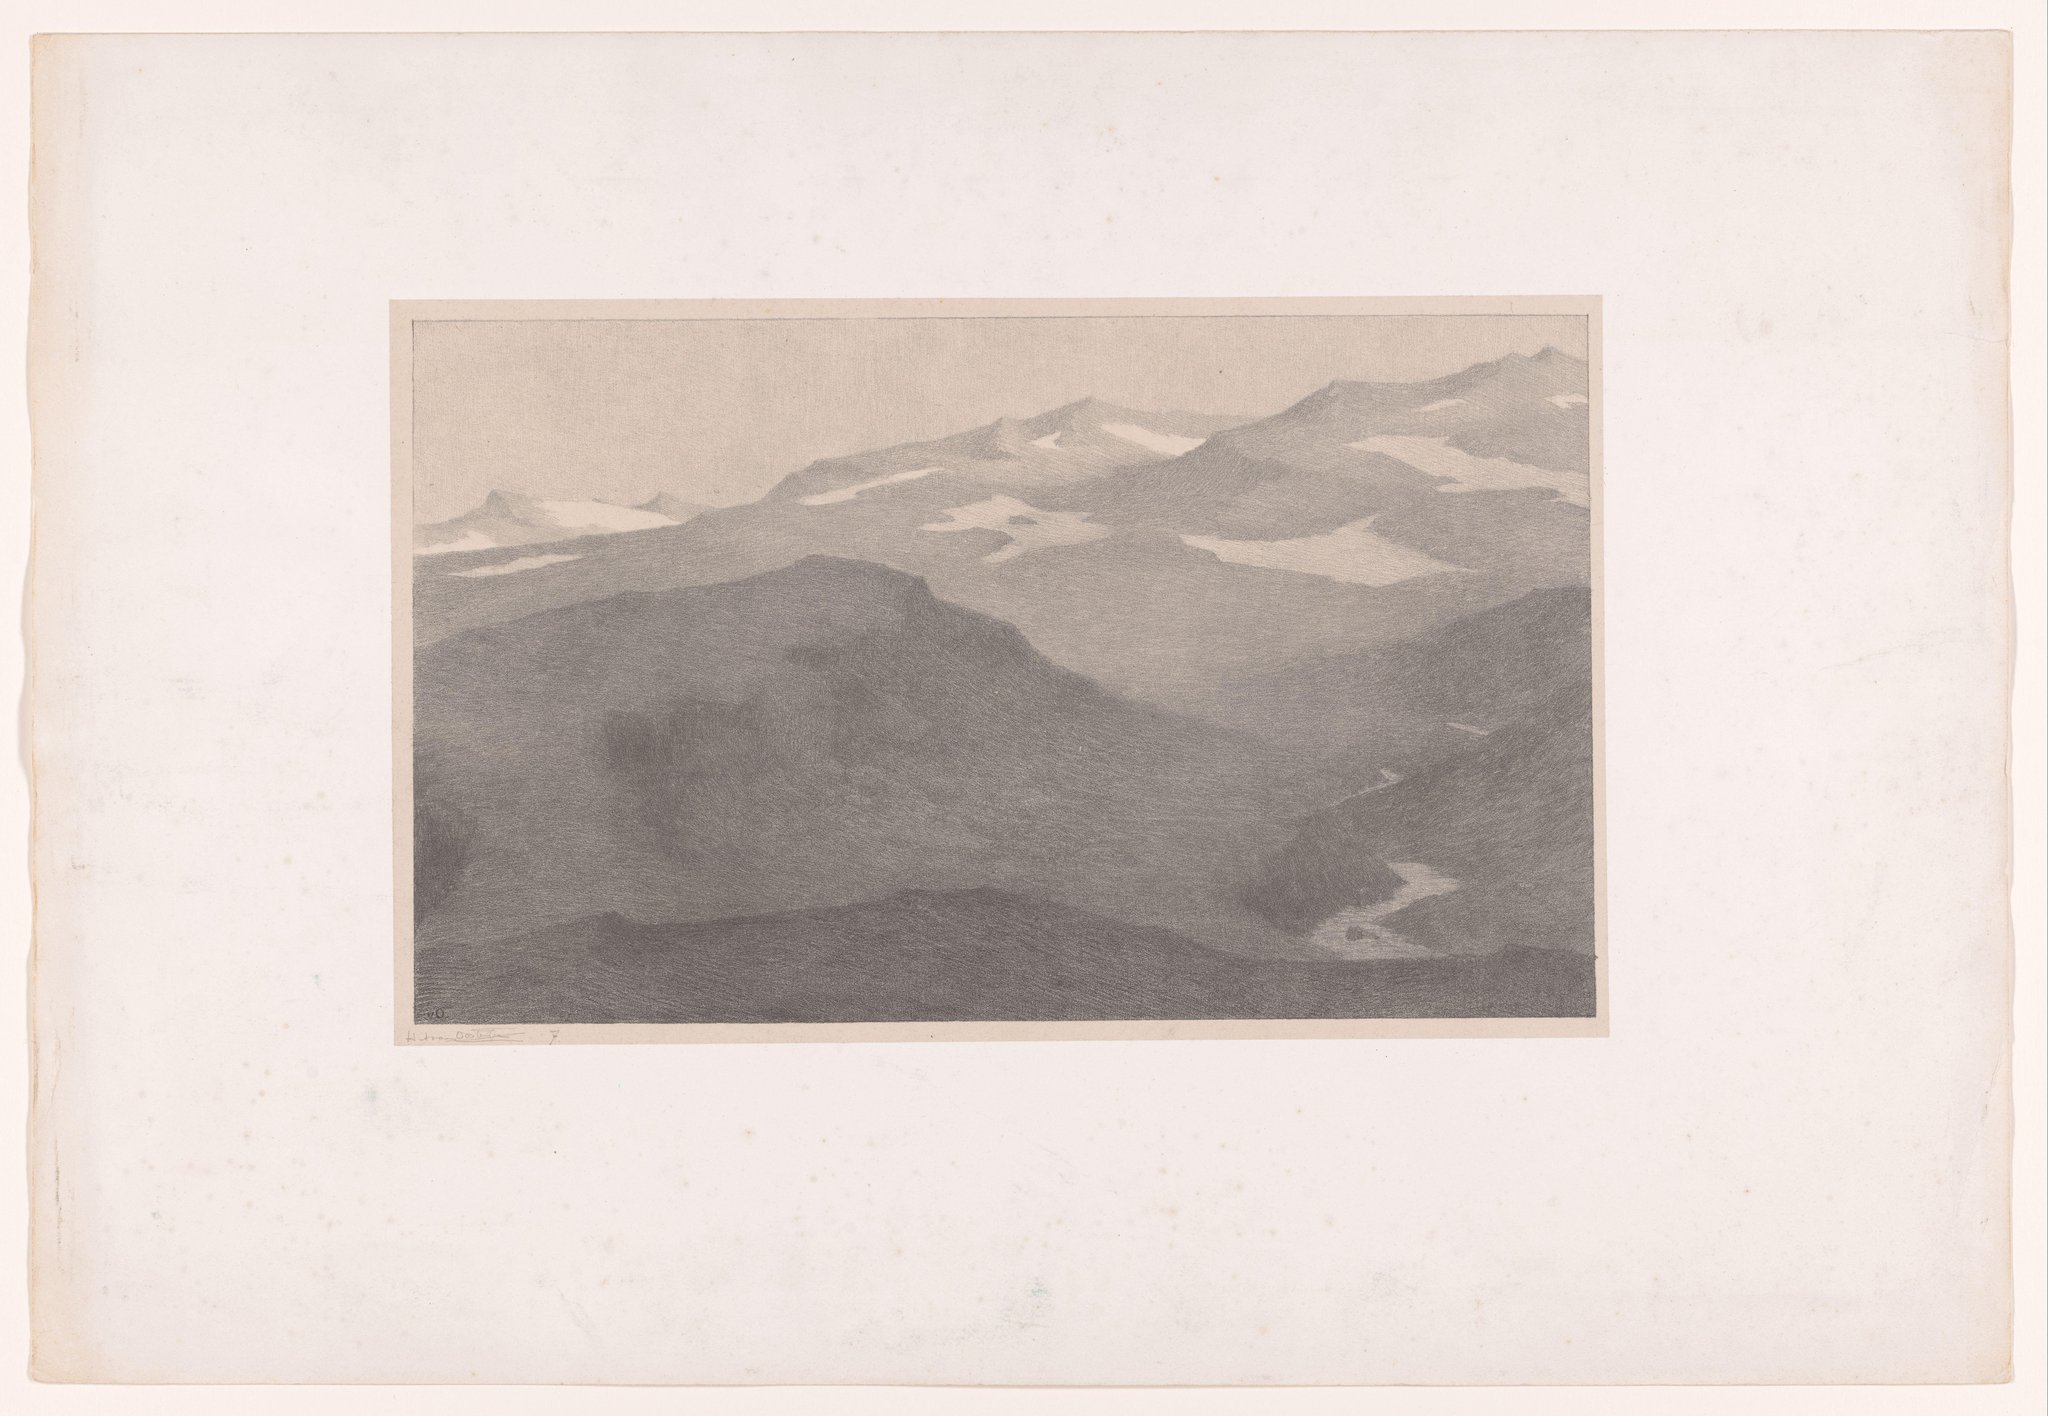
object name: print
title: Berglandschap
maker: hermannus adrianus van oosterzee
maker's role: draughtsman, painter, print maker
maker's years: 1863-1933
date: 1873-1933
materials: paper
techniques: lithograph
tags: mountains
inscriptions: collector's mark: Lugt 2228